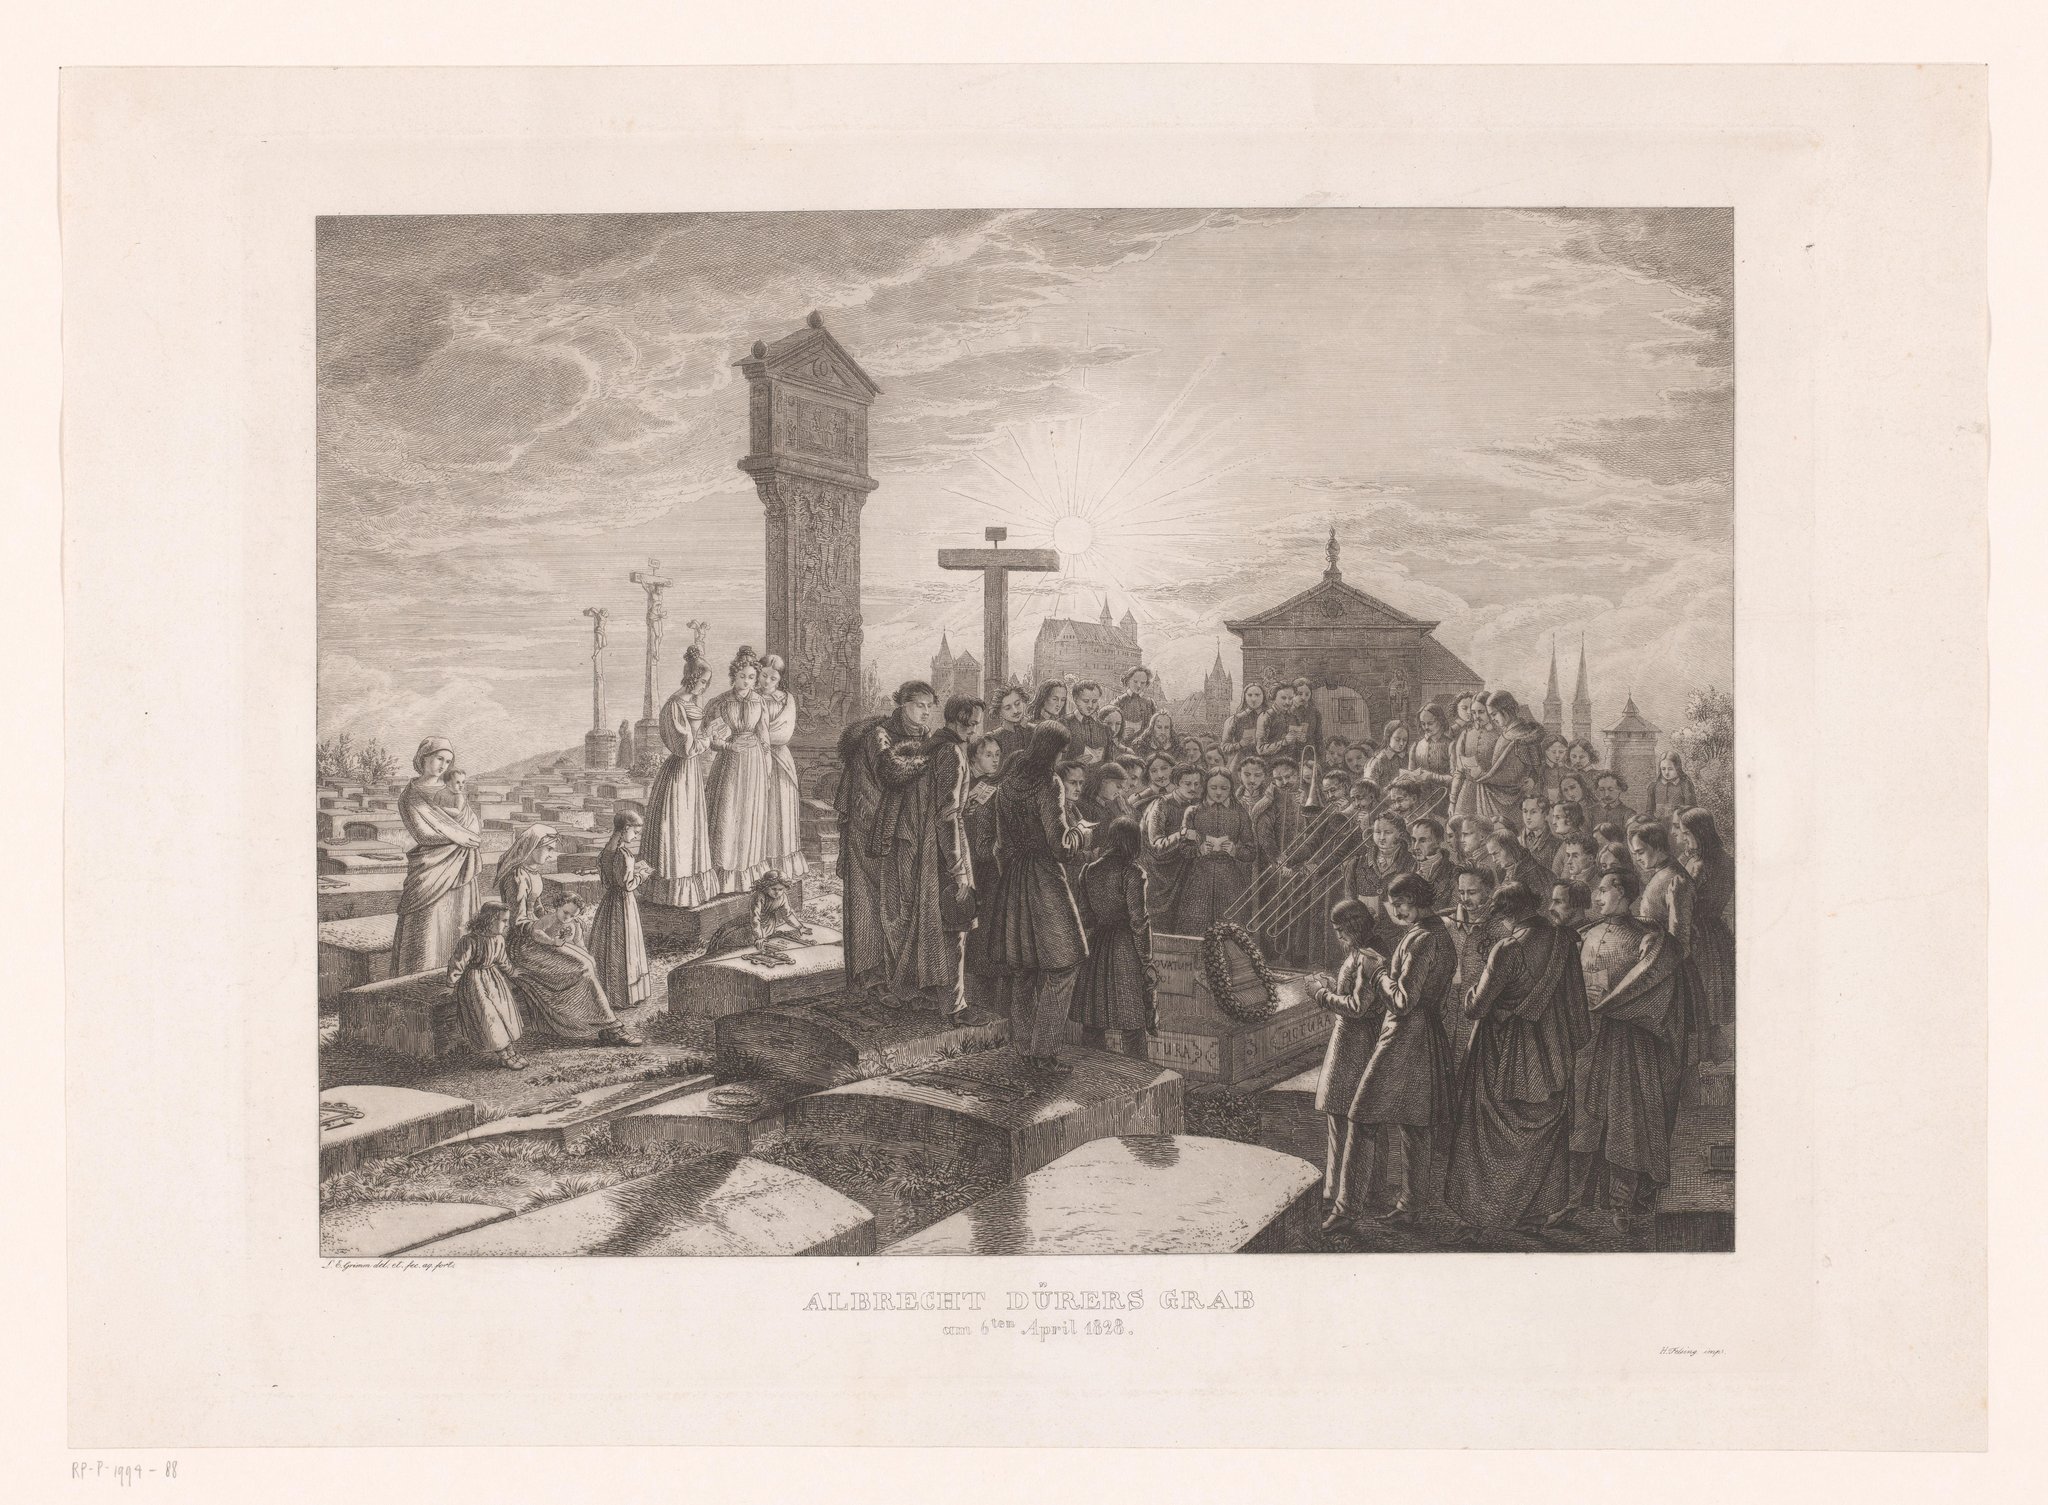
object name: print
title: Bijeenkomst bij het graf van Albrecht Dürer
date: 1828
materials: paper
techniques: etching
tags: commemoration of an artist, horn, trumpet, cornet, trombone, tuba, mourning customs, churchyard, cemetery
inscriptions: collector's mark: Lugt 2228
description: Ludwig Emil Grimm bezocht samen met beeldhouwer Werner Henschel het graf van Dürer op 6 april 1828, tijdens de herdenking van zijn 300e sterfte jaar. Waarschijnlijk zijn de twee kunstenaars links op de prent afgebeeld.